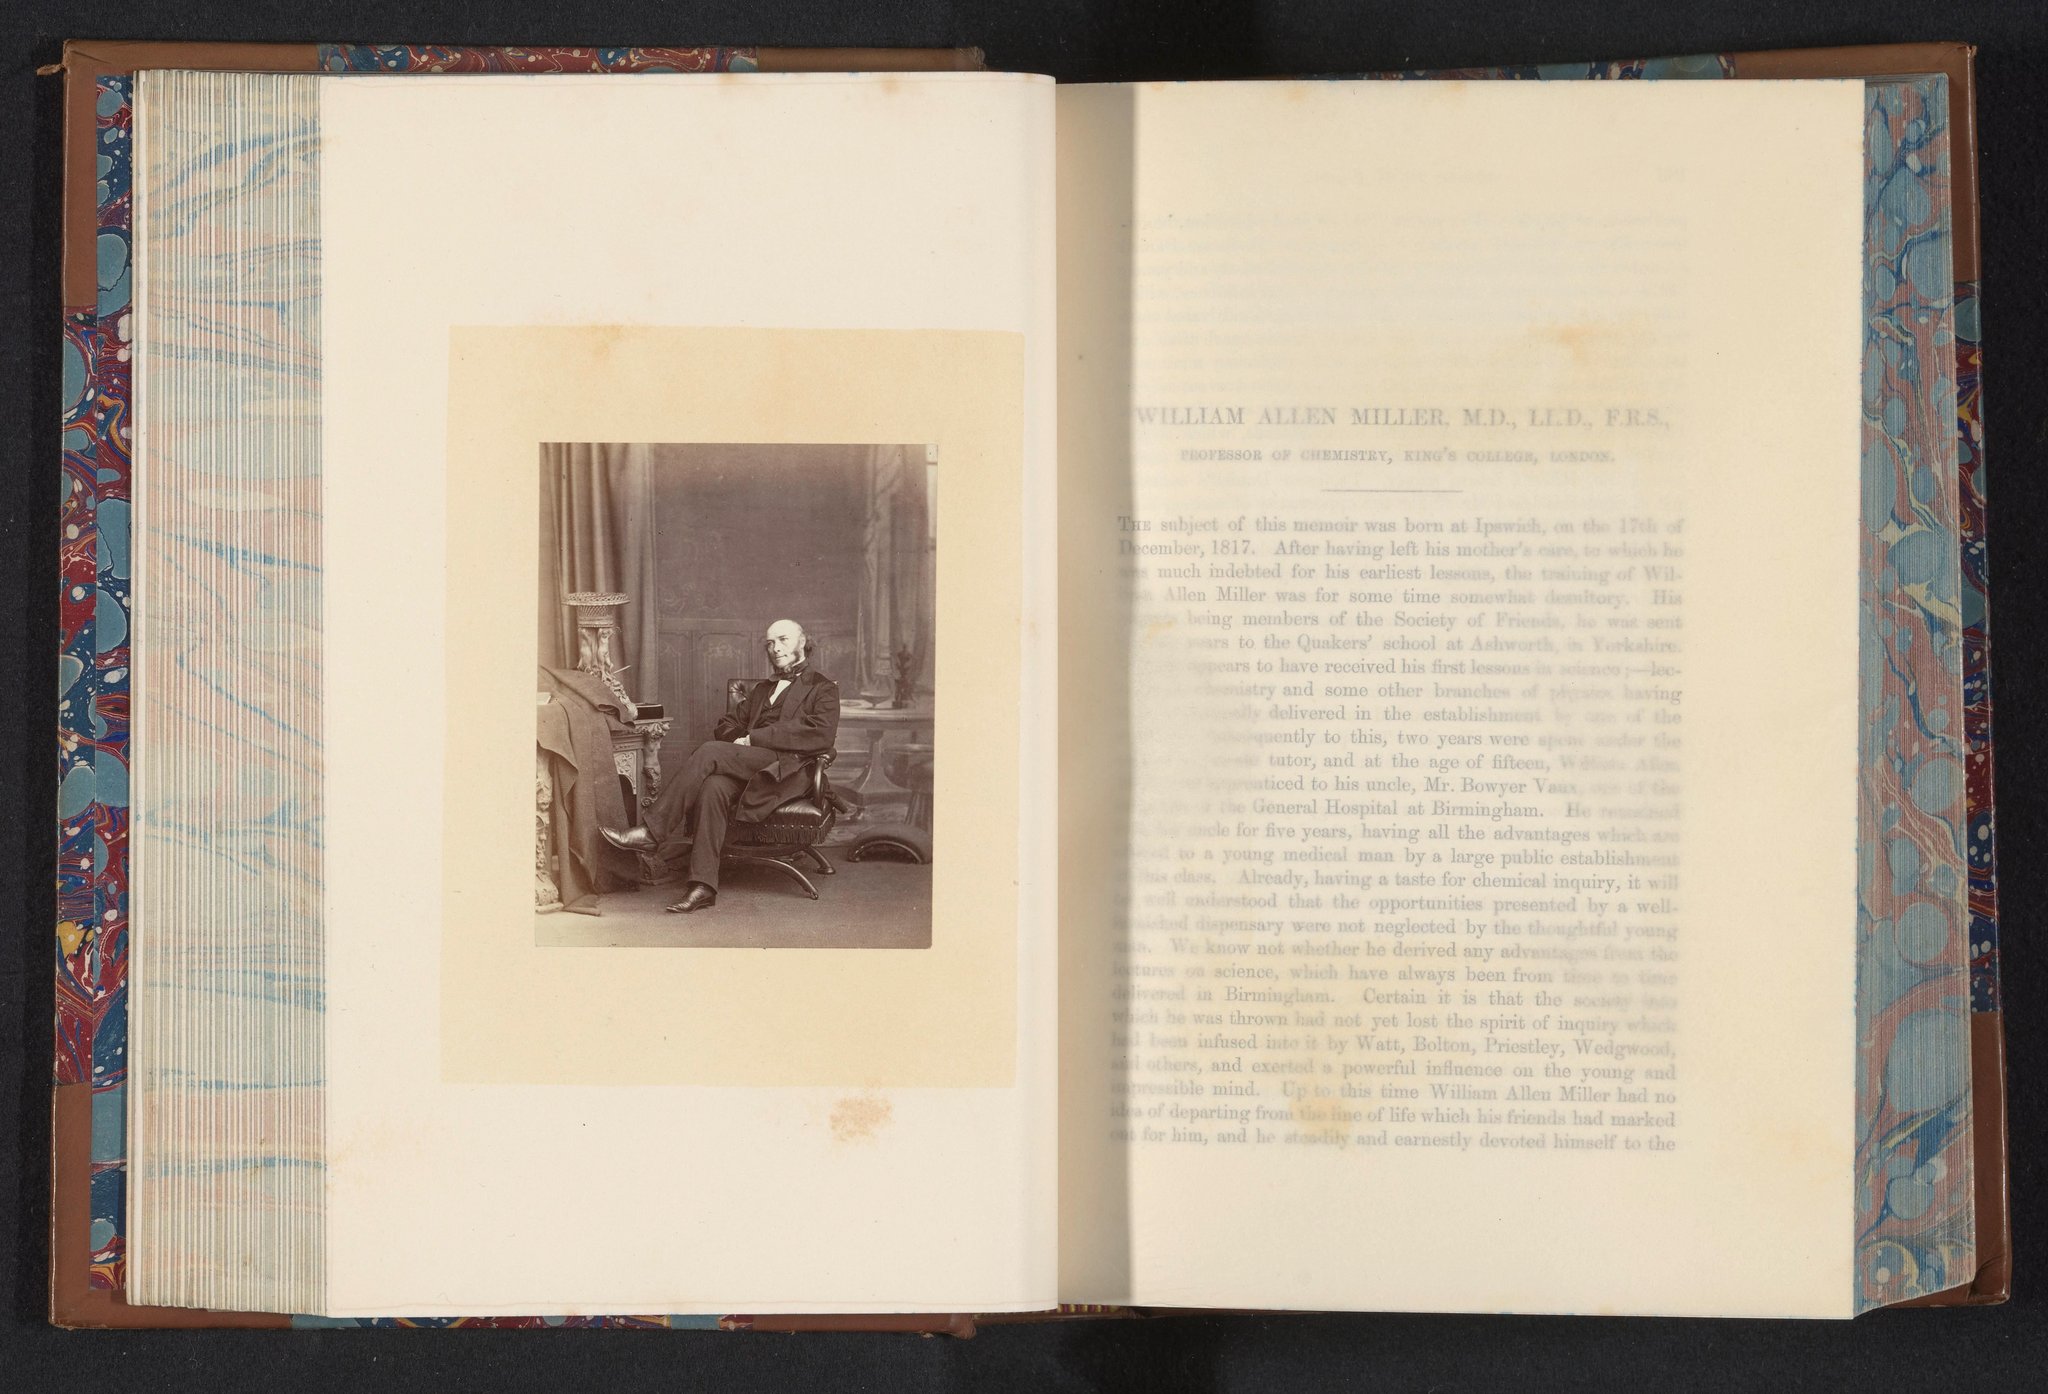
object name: page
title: Portret van William Allen Miller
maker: ernest edwards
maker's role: fotograaf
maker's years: 1837-1903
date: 1853-1867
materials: photographic support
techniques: albumen print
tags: adult man, historical persons